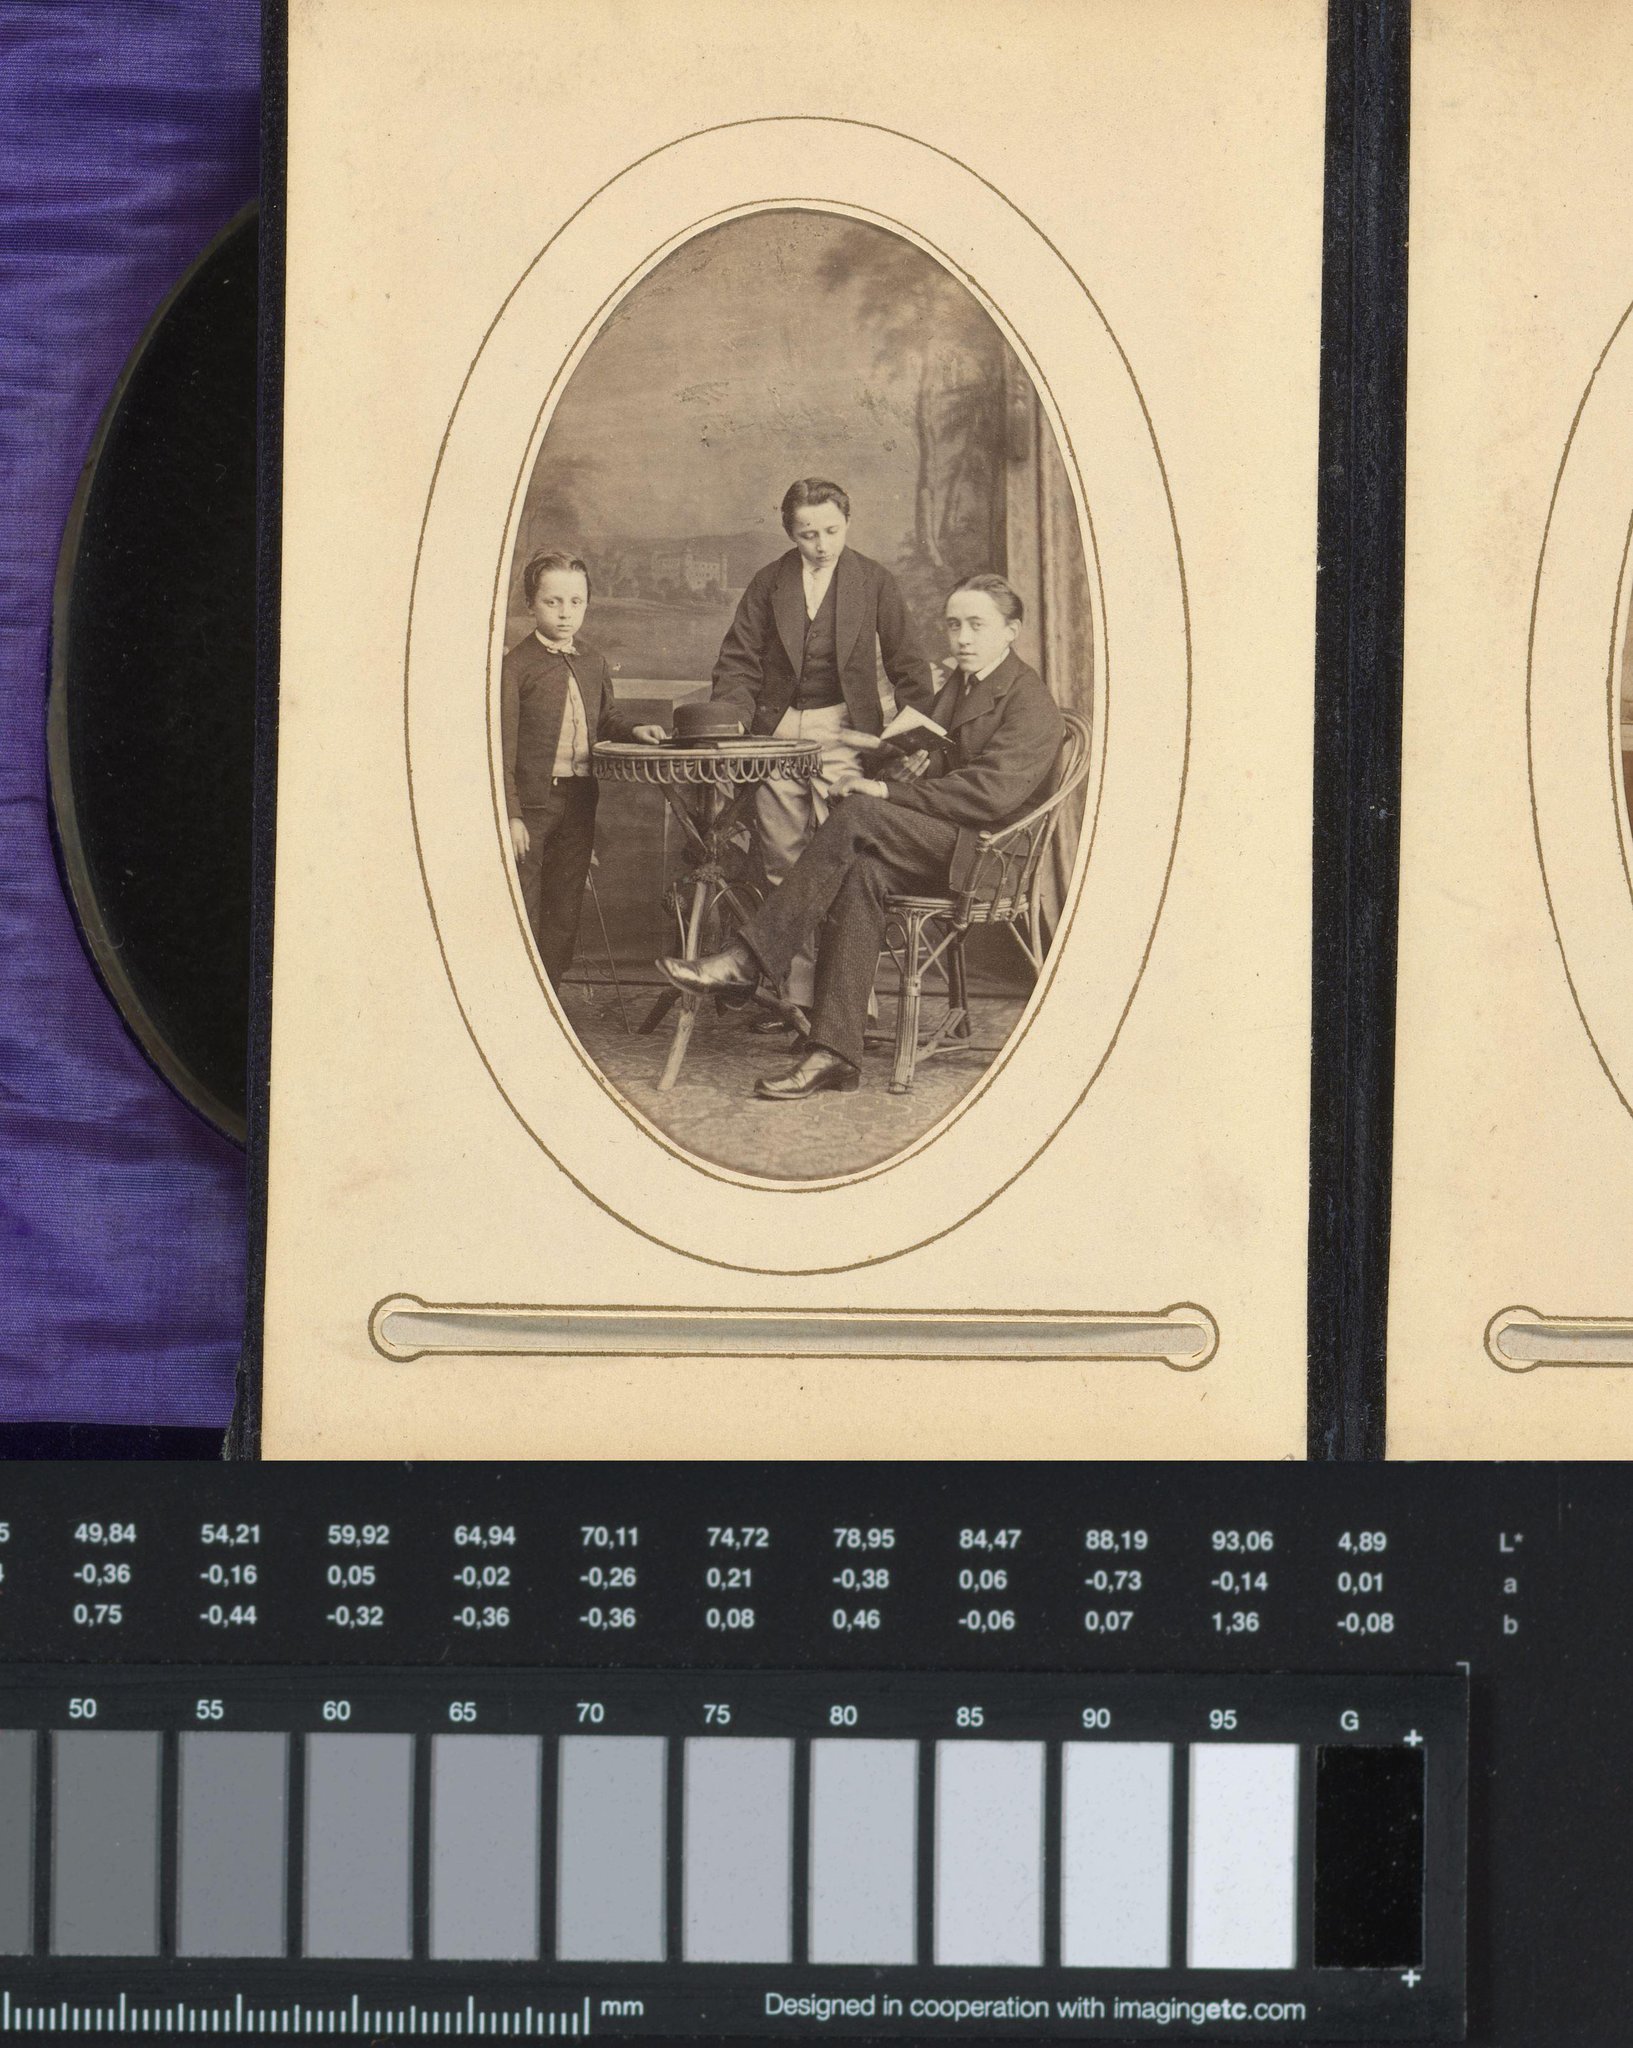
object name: carte de visite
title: Portret van drie jongens rond een tafel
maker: bernardus theodorus van loo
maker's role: print maker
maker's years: 1816-1892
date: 1869-1873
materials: cardboard, photographic support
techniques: albumen print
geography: rotterdam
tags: boy (child between toddler and youth) (+ three persons), historical persons, table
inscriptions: inscription: ‘B.T. VAN LOO. PHOTOGRAAF/ van/ Z.M. den Koning,/ ROTTERDAM/ Hugo de Groot-straat./ Wÿk 13 No. 496.’